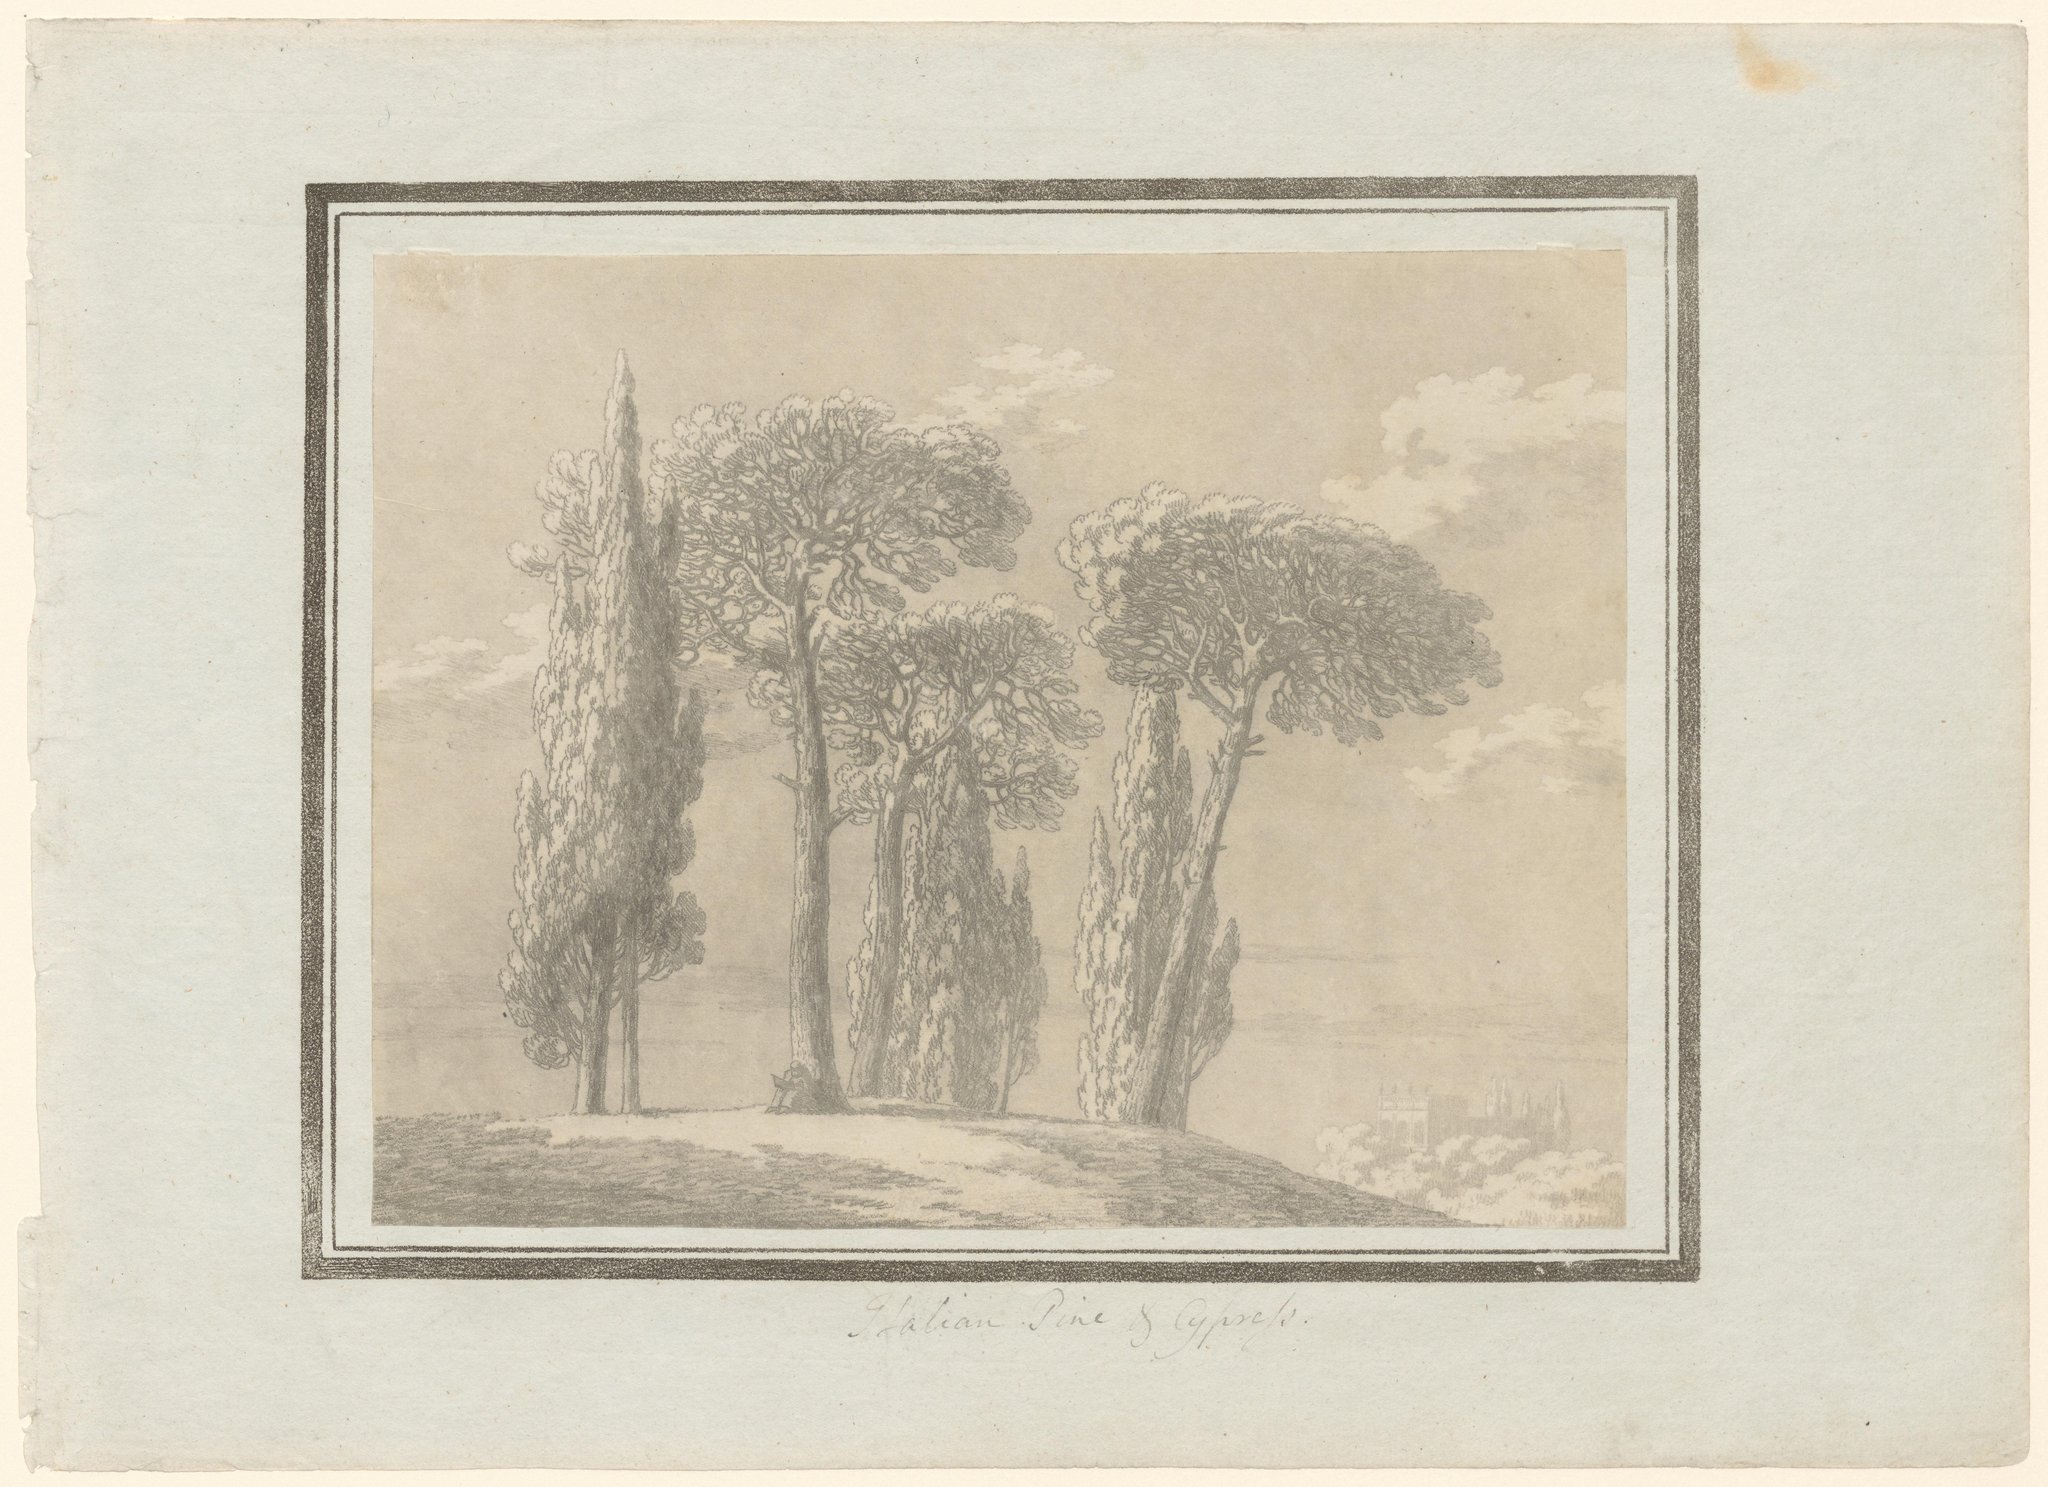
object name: print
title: Italiaanse pijnboom en cipres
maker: john robert cozens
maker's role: draughtsman, print maker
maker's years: 1752-1797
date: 1789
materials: paper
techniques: aquatint, soft ground etching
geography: london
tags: trees: cypress, trees: pine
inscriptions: collector's mark: Lugt 2760, collector's mark: Lugt 2228, title: ‘Italian Pine & Cypress.’